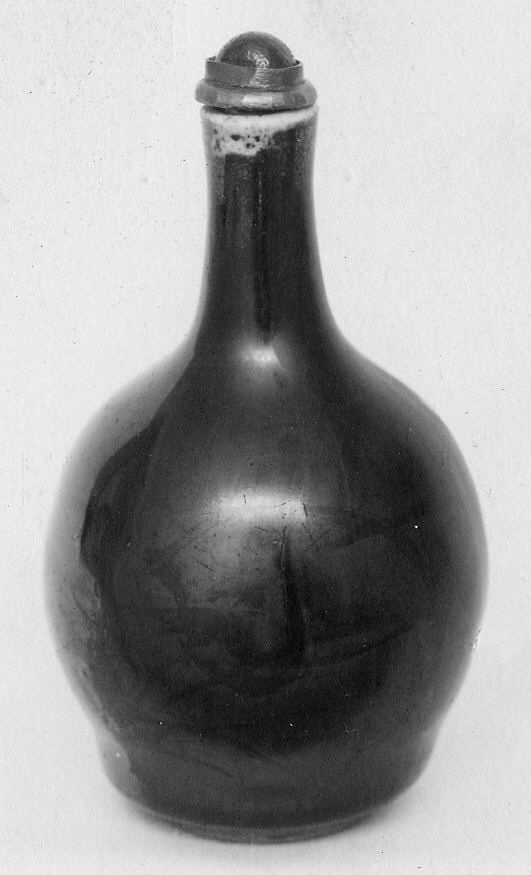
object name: snuff bottle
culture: chinese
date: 1801-1900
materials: porcelain